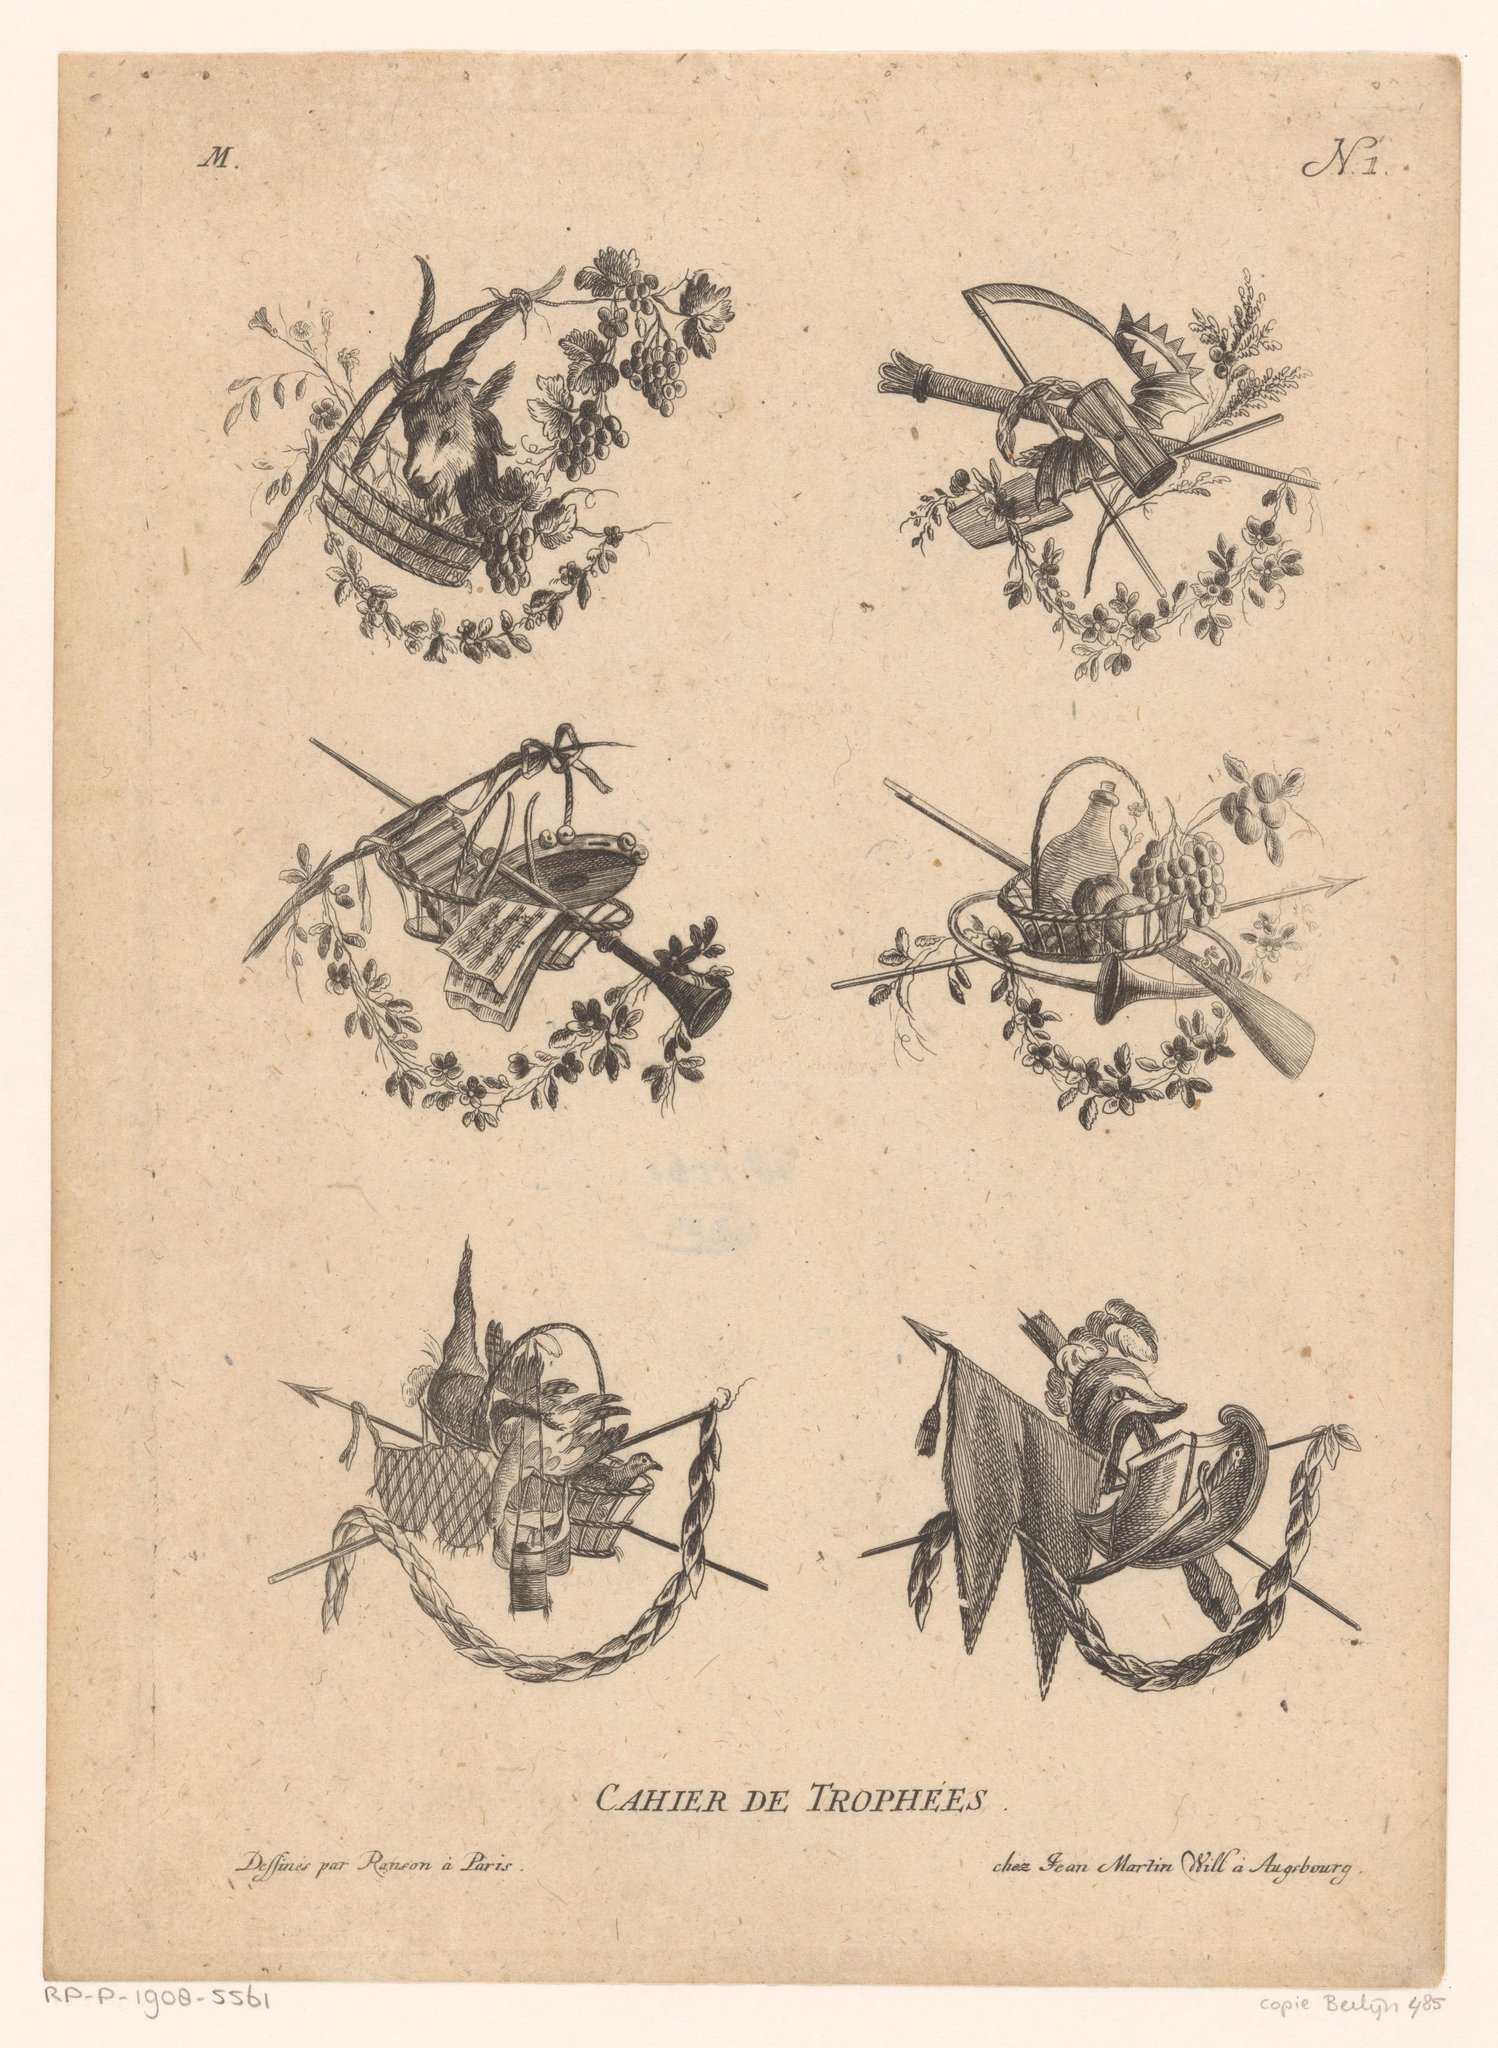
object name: print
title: M Cahier de Trophées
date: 1772-1806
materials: paper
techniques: etching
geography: paris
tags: musical instruments; group of musical instruments, trophy, i.e.: decorative arrangement of symbolic or typical objects ~ ornament, hunting, chase, weapons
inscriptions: collector's mark: Lugt 2228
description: Zes trofeeën met diverse attributen zoals geschoten wild, manden, een zeis, kroon en gevleugelde zandloper, muziekinstrumenten en een helm, schild en wapens.